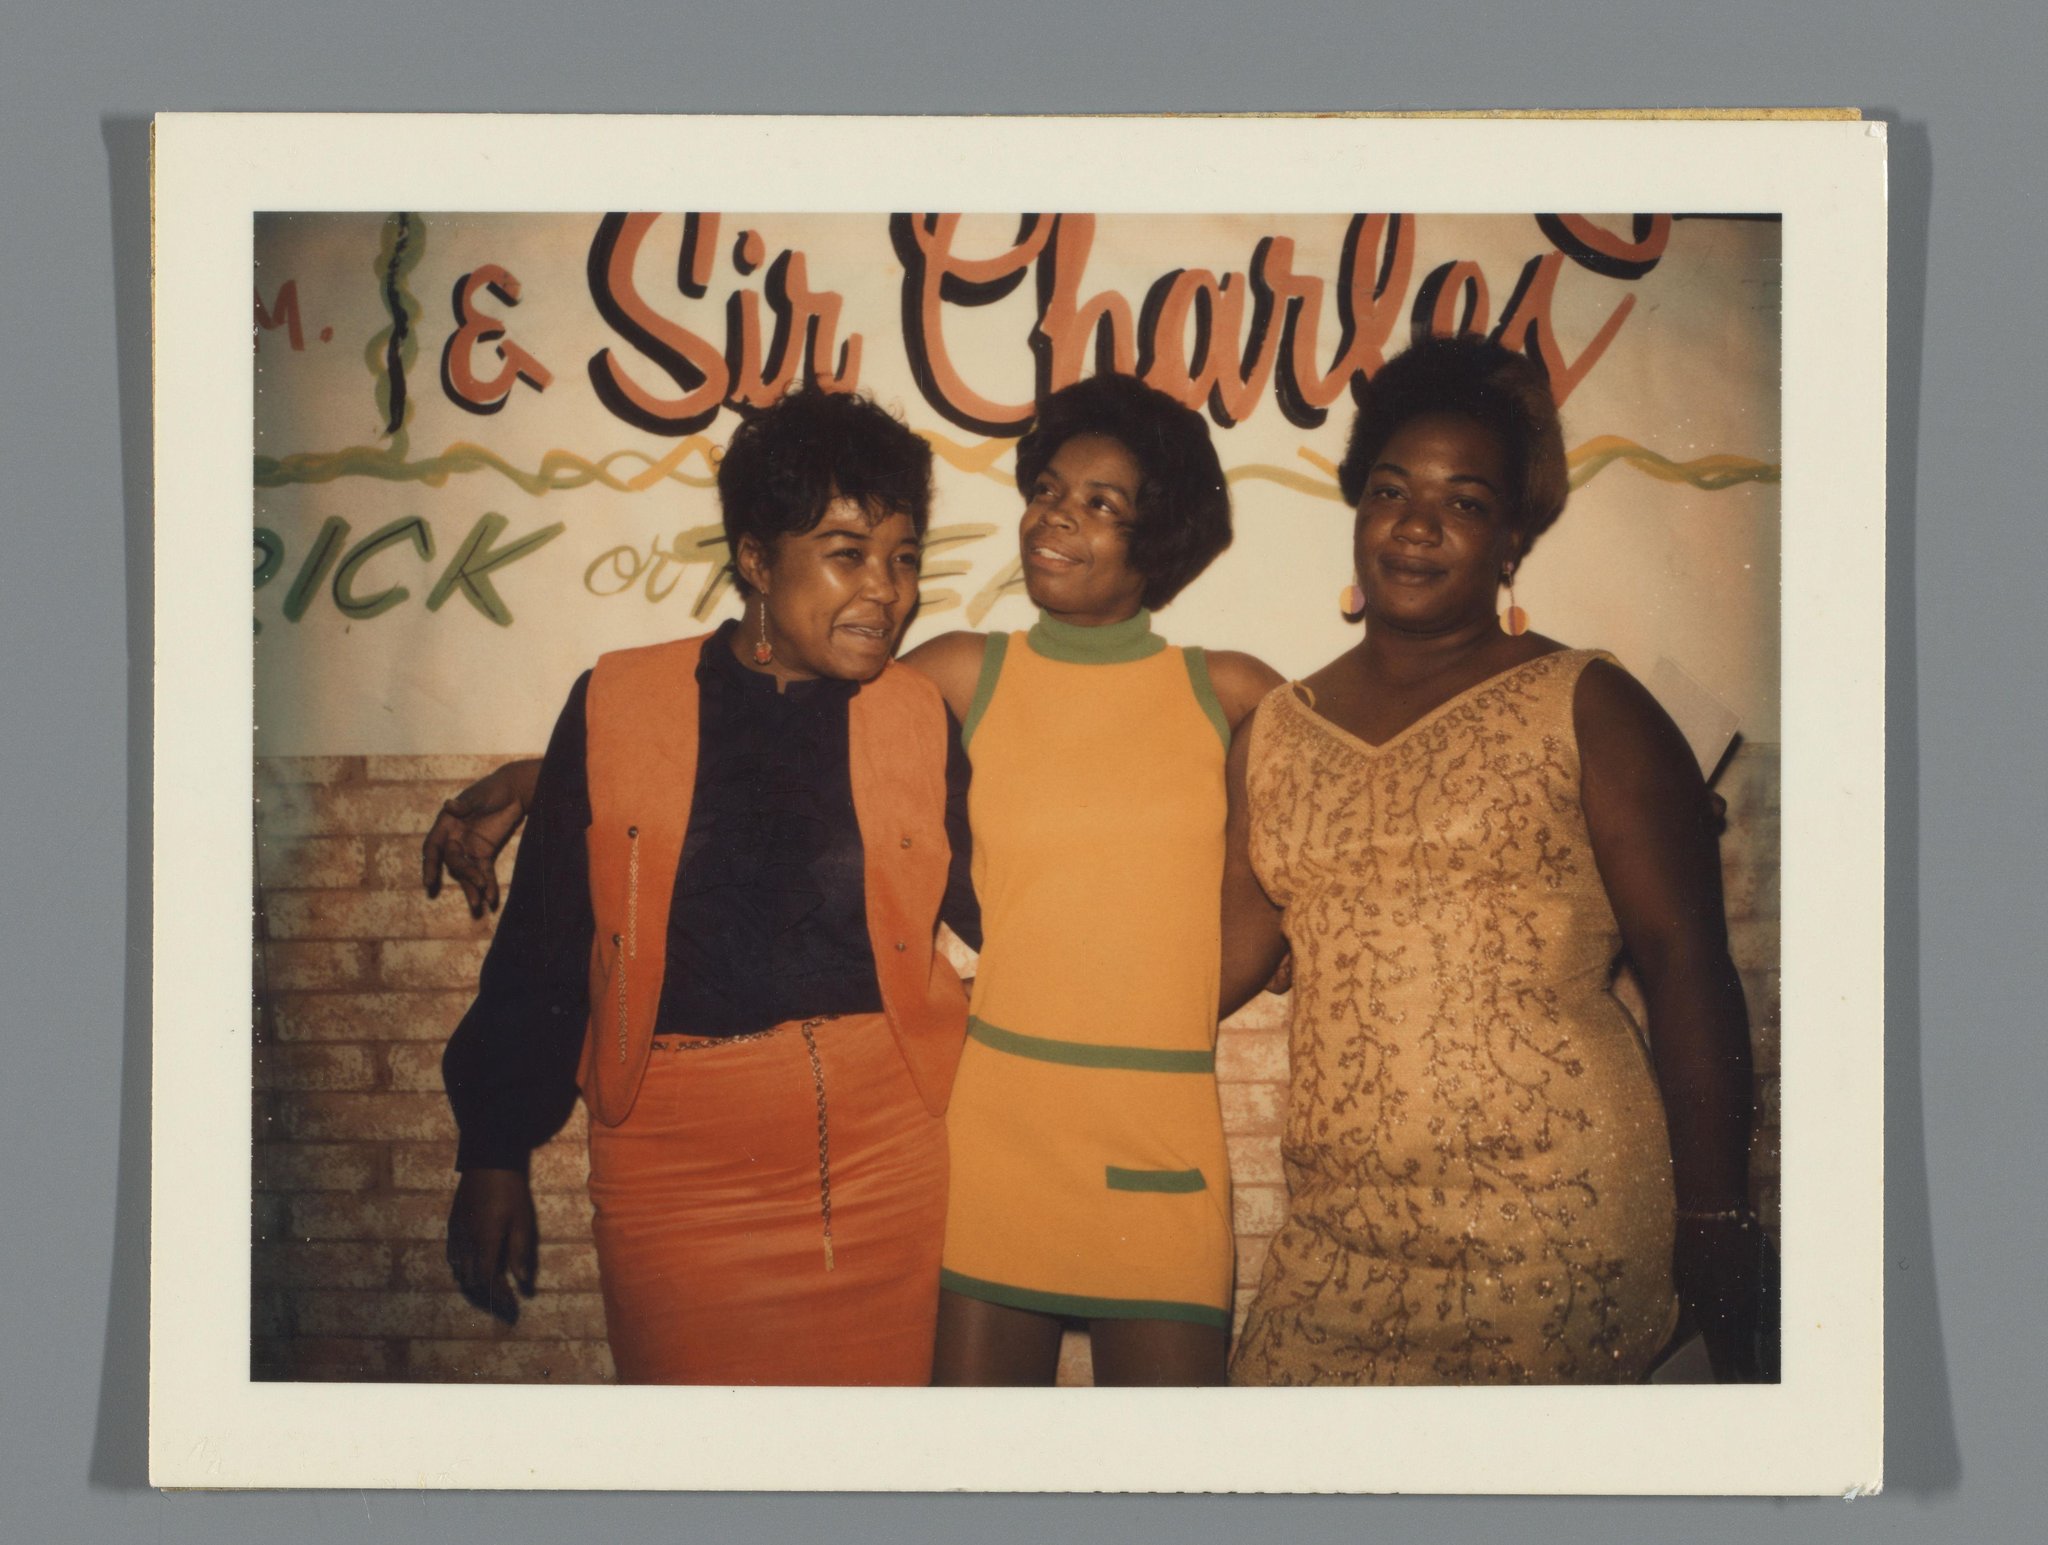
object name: photograph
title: Drie donkere vrouwen poseren arm in arm voor ... & Sir Charles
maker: Anonymous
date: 1965-1975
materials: photographic support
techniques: polaroid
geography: united states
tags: united states of america